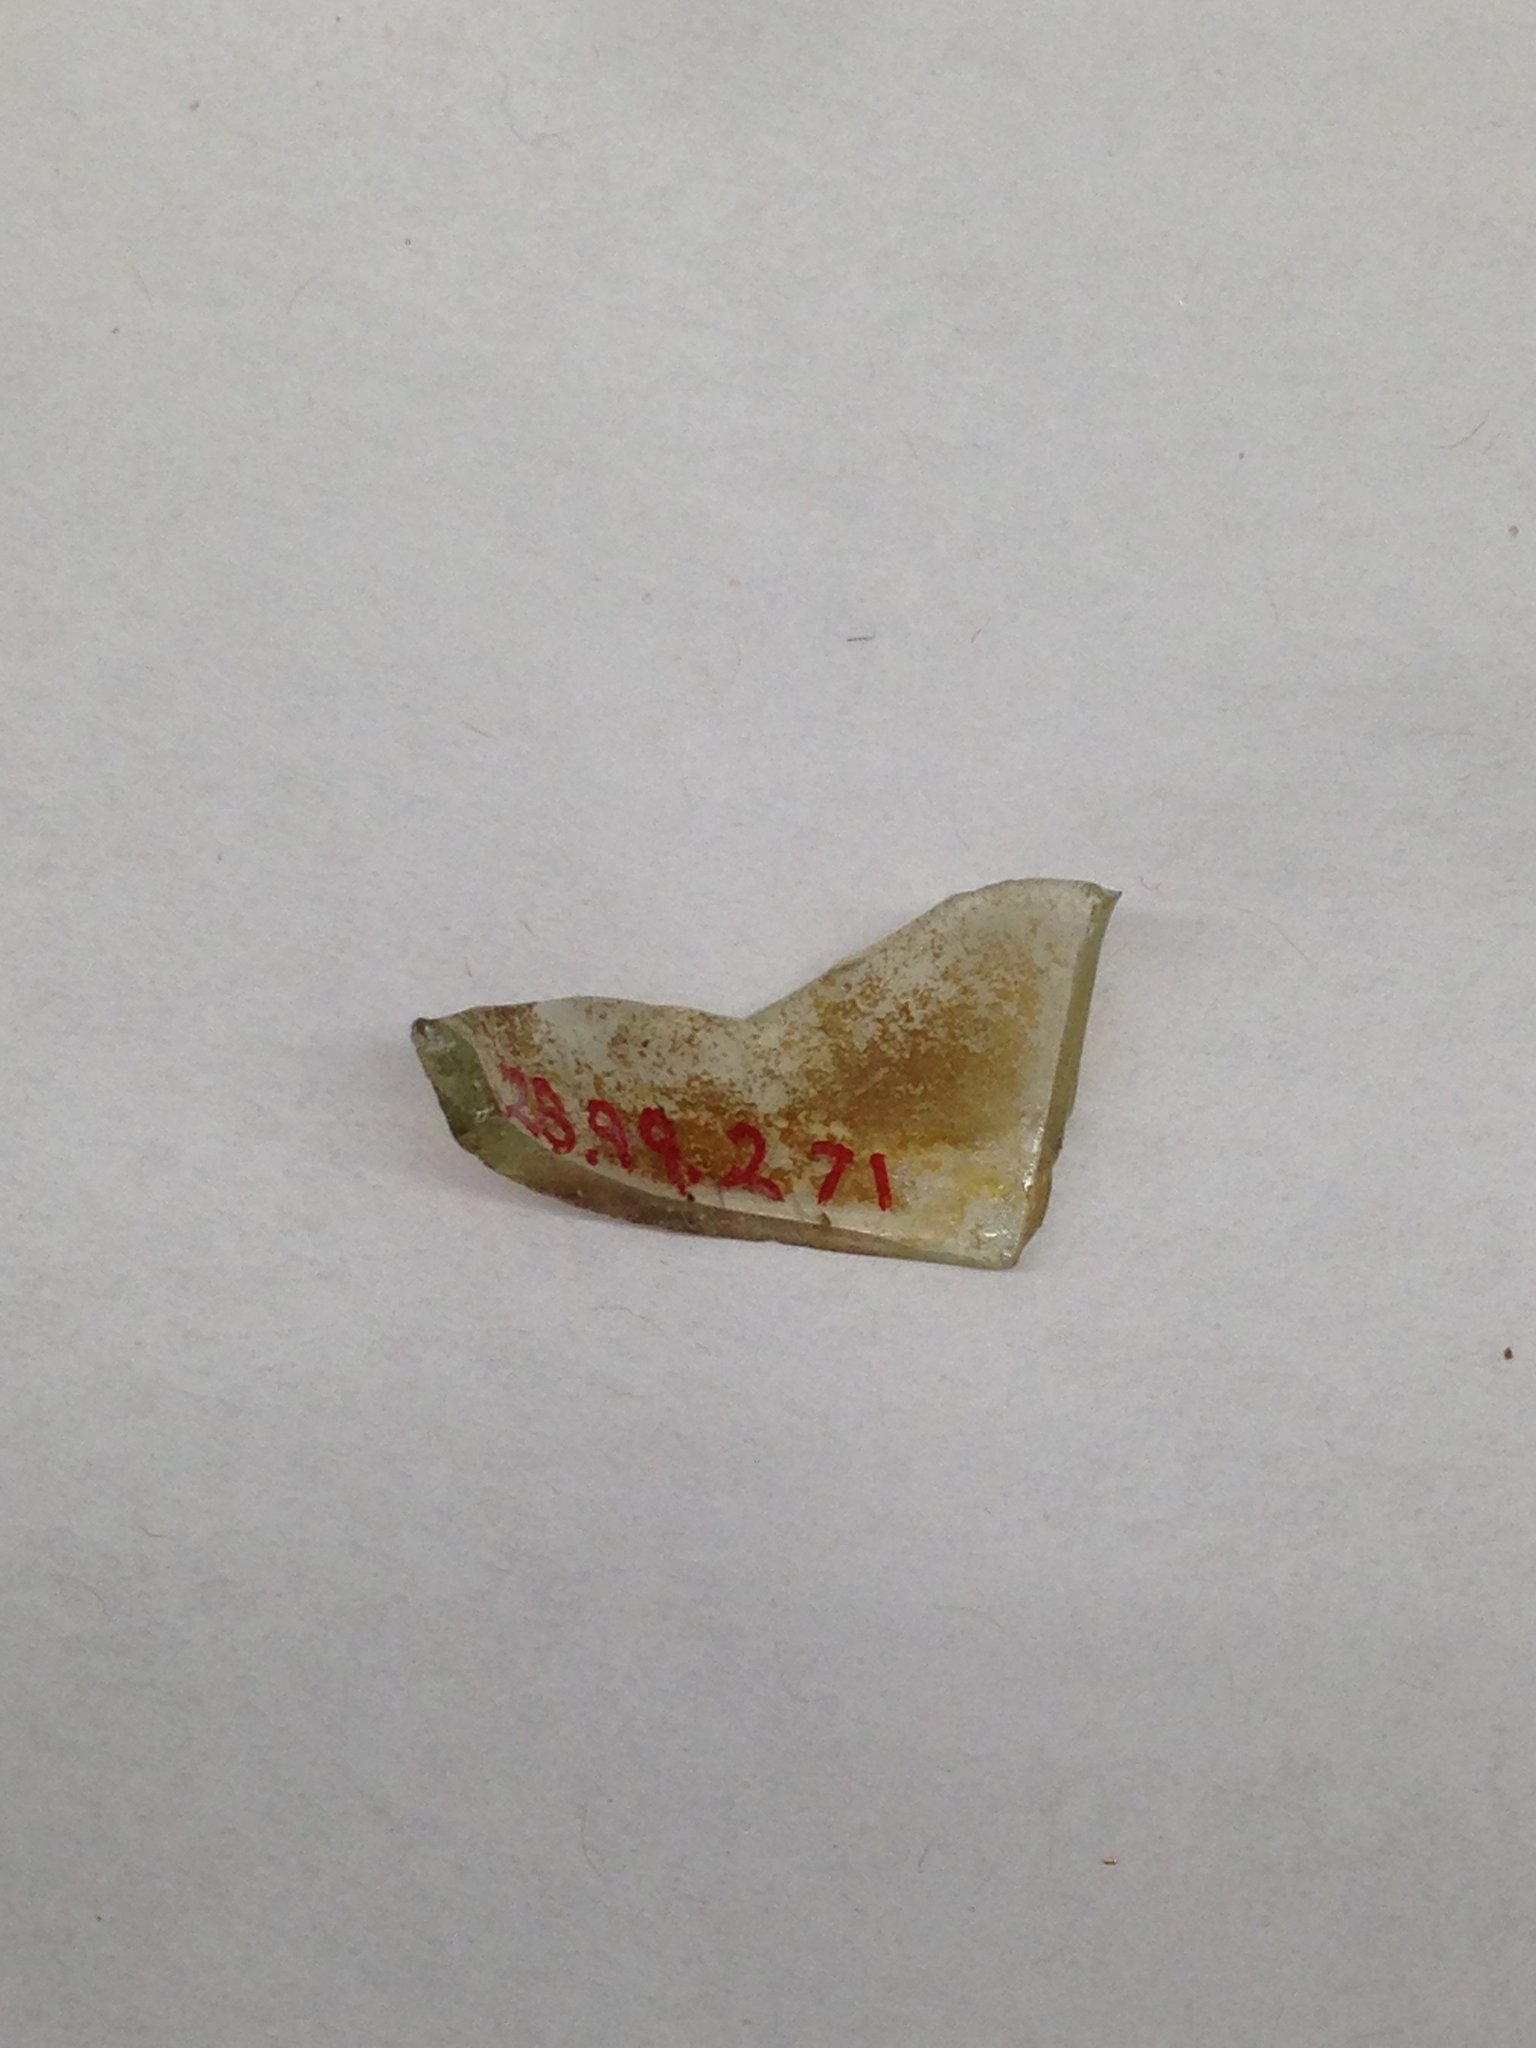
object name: fragment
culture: european or middle eastern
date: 1150-1250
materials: ceramic, glass